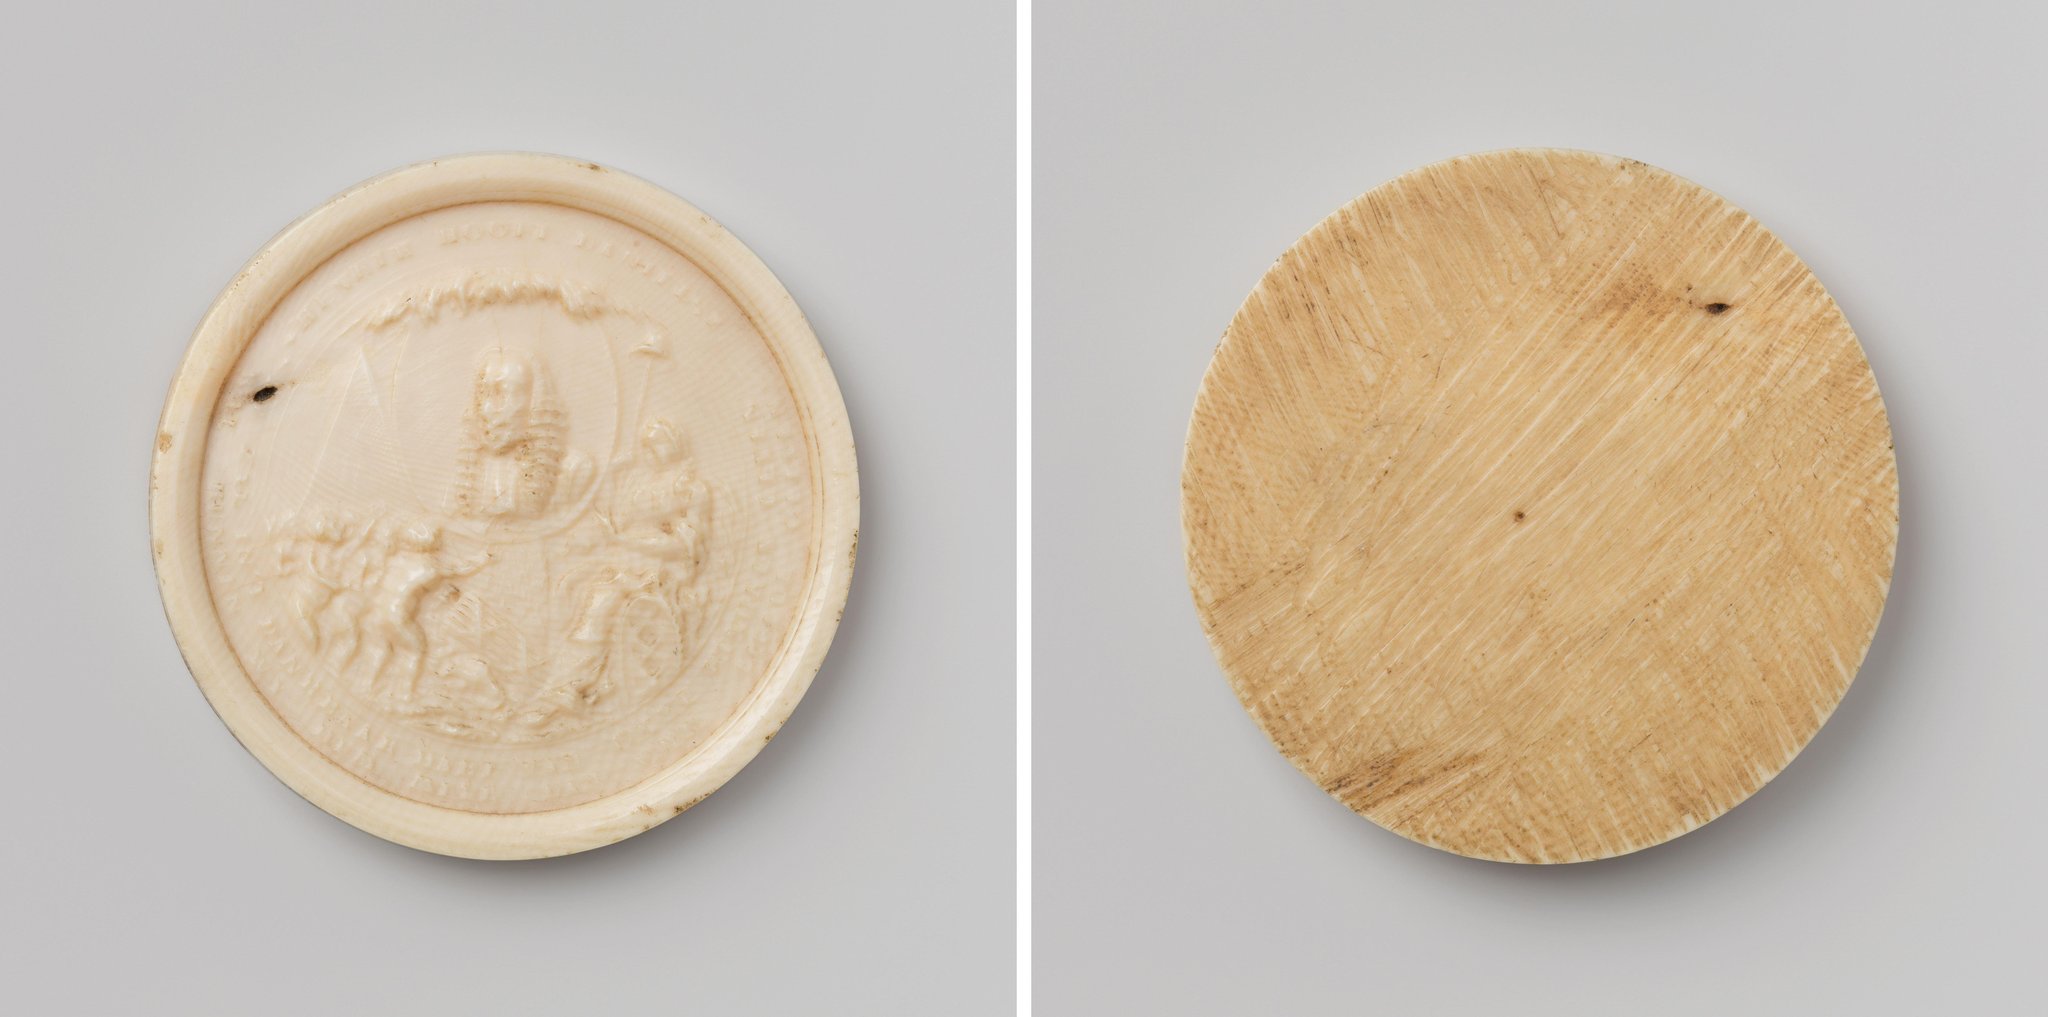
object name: locket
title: Overlijden van Hendrik Danielsz. Hooft, burgemeester van Amsterdam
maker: Anonymous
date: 1794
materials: ivory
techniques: striking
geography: netherlands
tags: amsterdam, mayor, hendrik danielsz. hooft